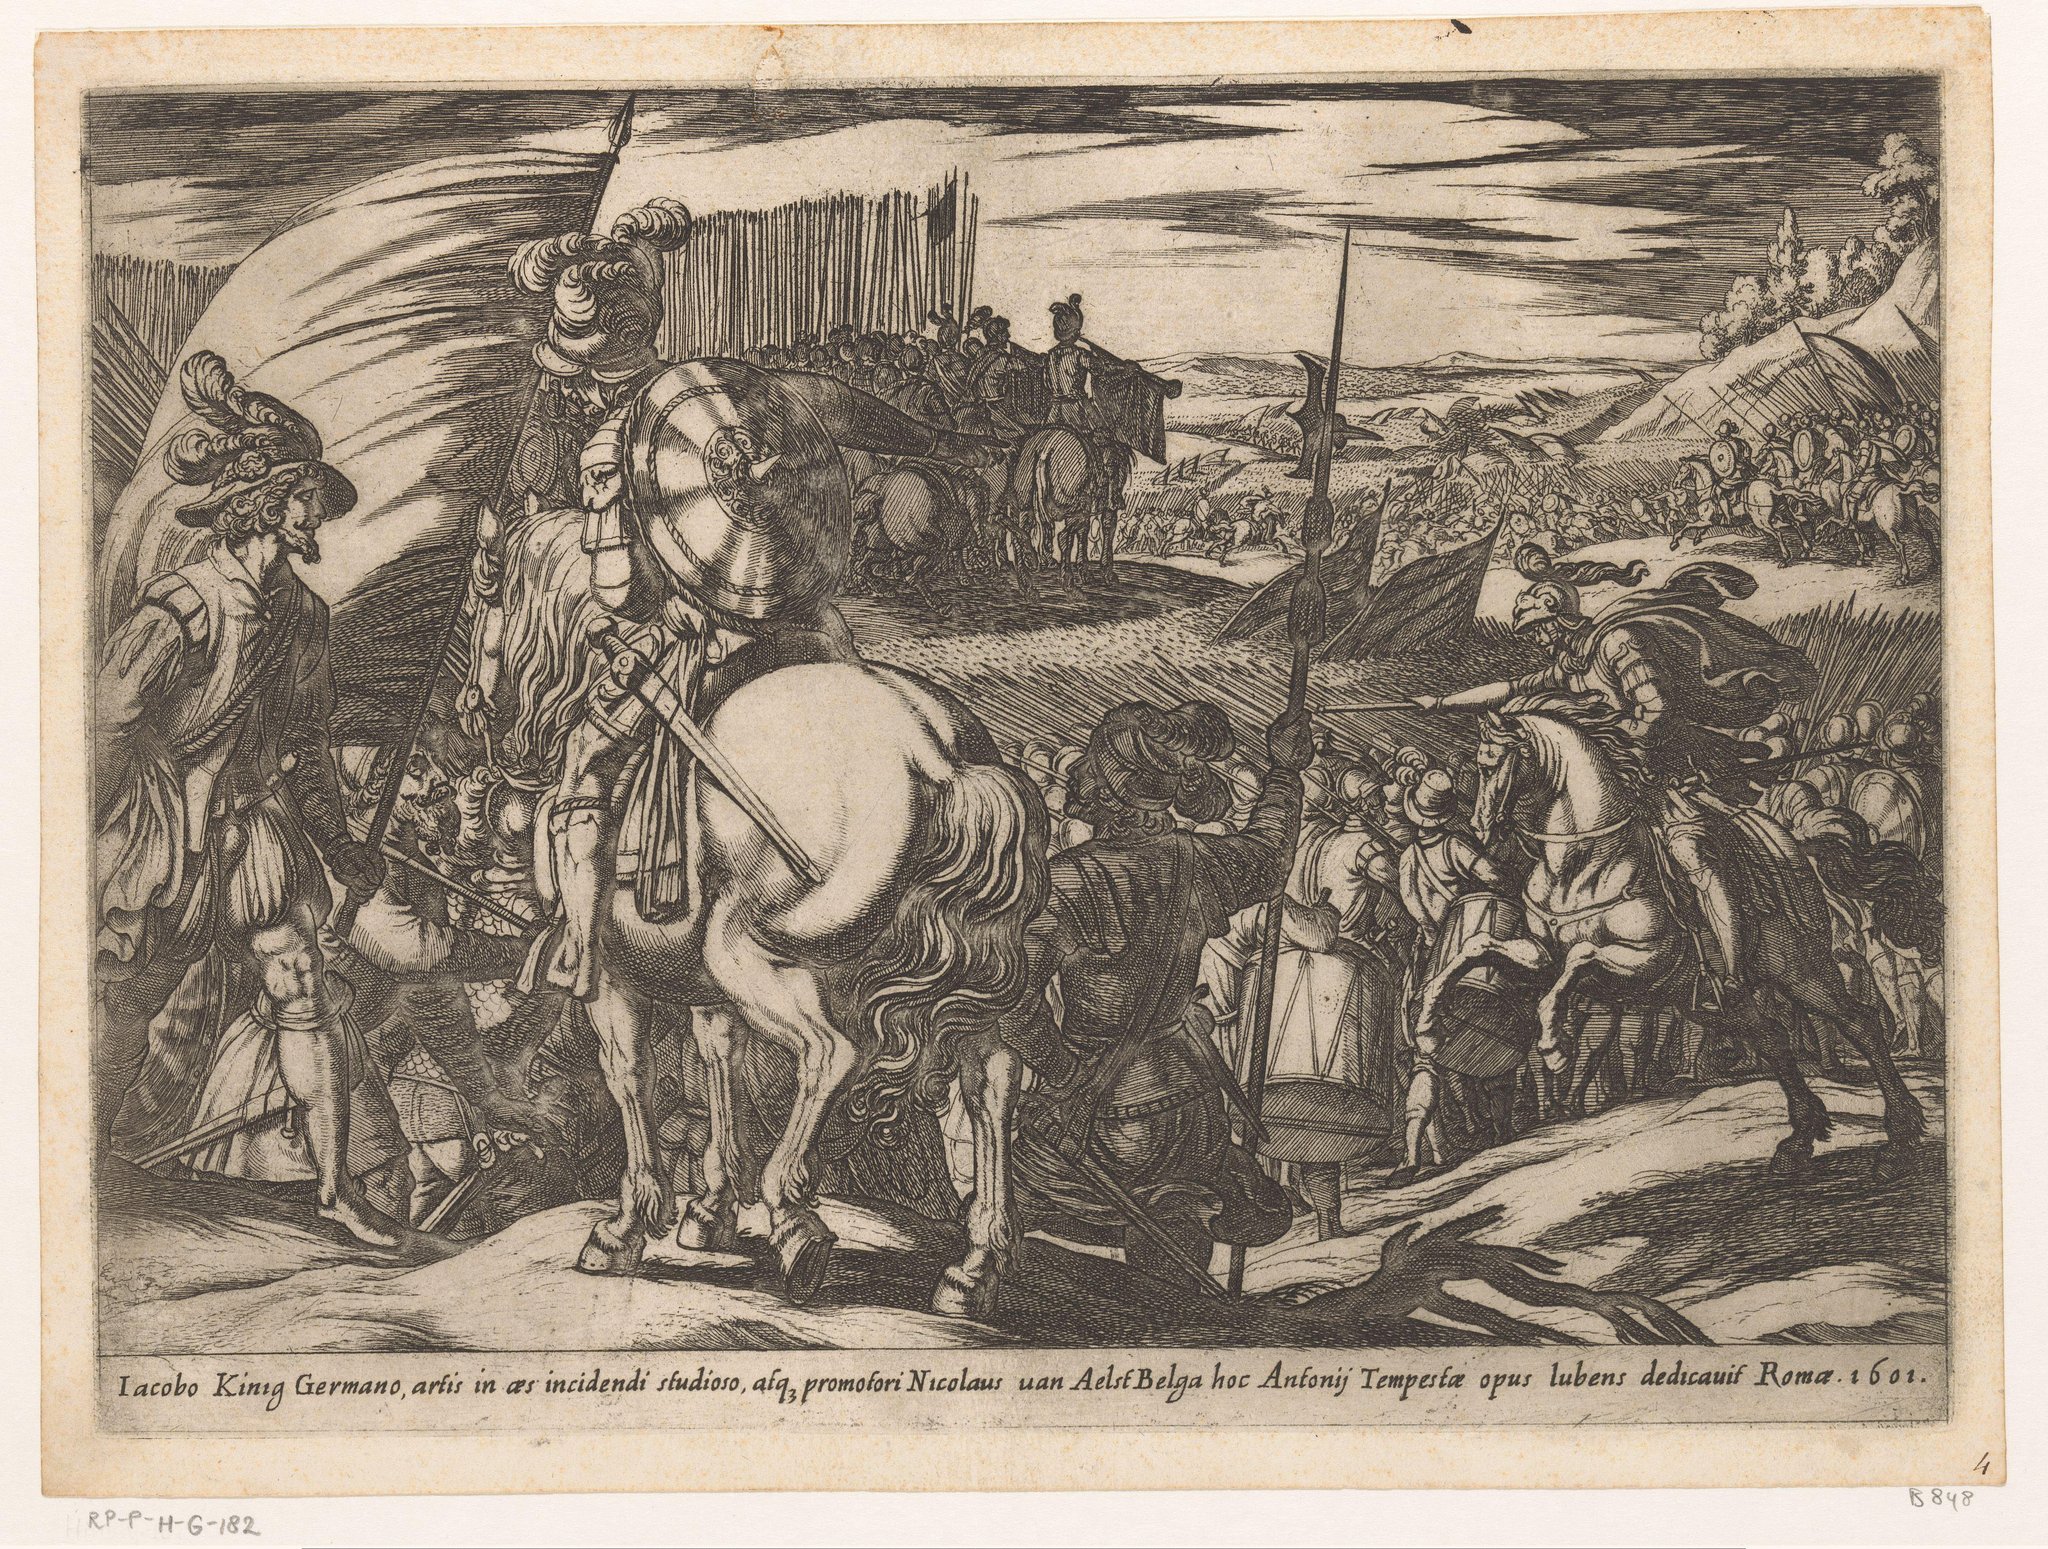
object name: print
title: Gevechtsscènes (serie 3)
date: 1601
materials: paper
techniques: etching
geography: rome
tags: battle, warfare; military affairs (+ cavalry, horsemen), the soldier; the soldier's life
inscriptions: collector's mark: Lugt 11, number: ‘4’, collector's mark: ‘Hinloopen’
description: Een leger bereidt zich voor op de aanval. Links een vaandeldrager en een officier te paard.